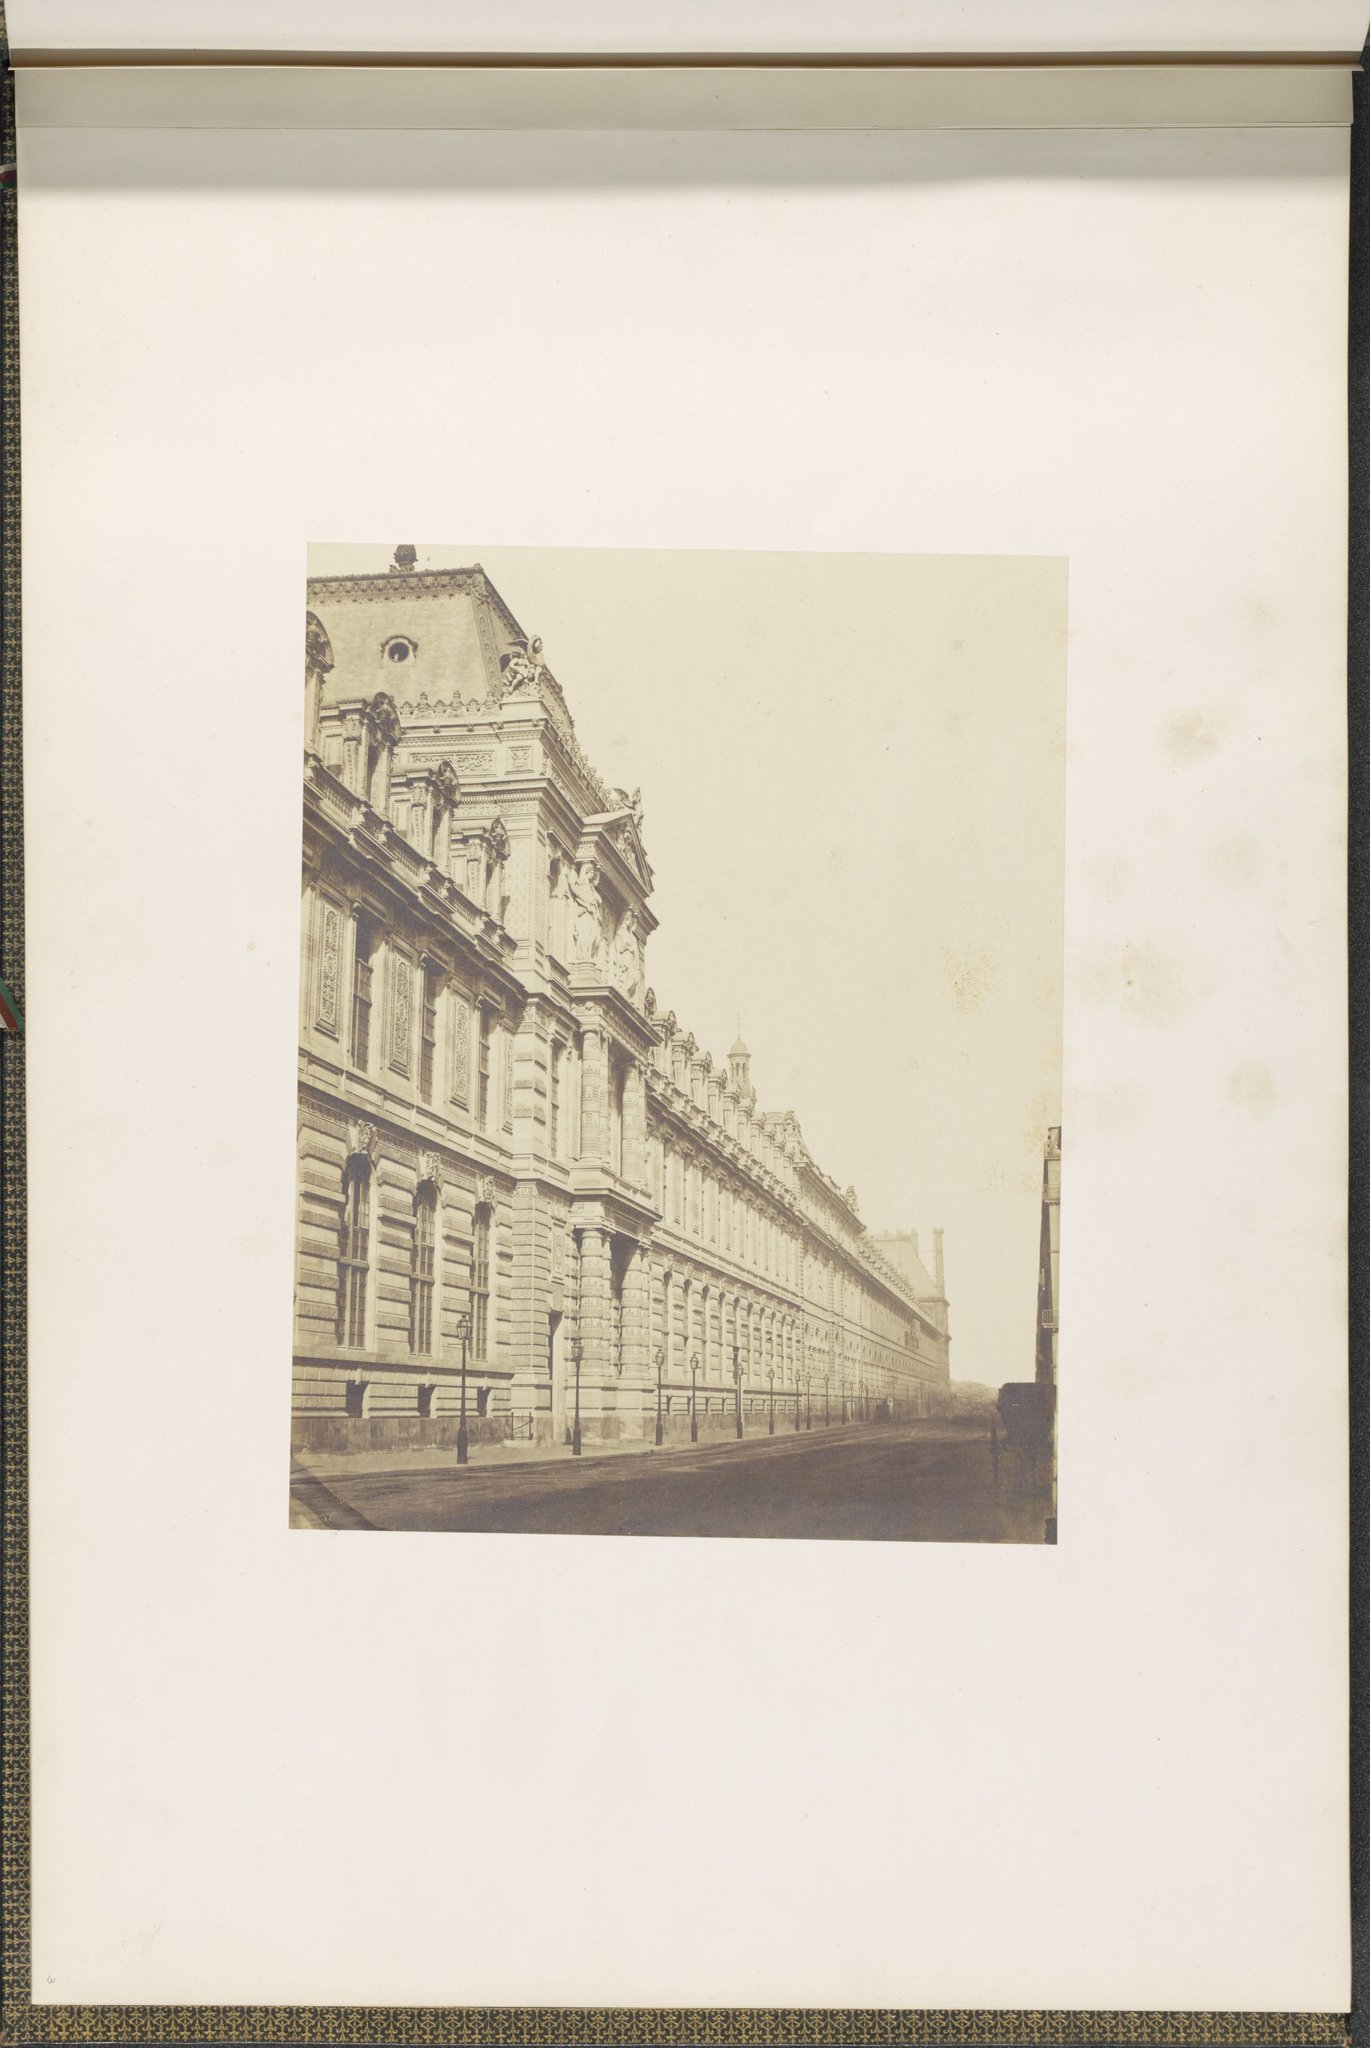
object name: photograph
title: Gevel van het Pavillon Richelieu in het Palais du Louvre en de Rue de Rivoli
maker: édouard denis baldus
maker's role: fotograaf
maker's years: 1813-1889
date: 1857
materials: paper, photographic support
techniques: salted paper print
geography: paris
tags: permanent exhibition, museum, façade (of house or building), paris, tuileries palace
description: Onderdeel van Réunion des Tuileries au Louvre 1852-1857, album 4.